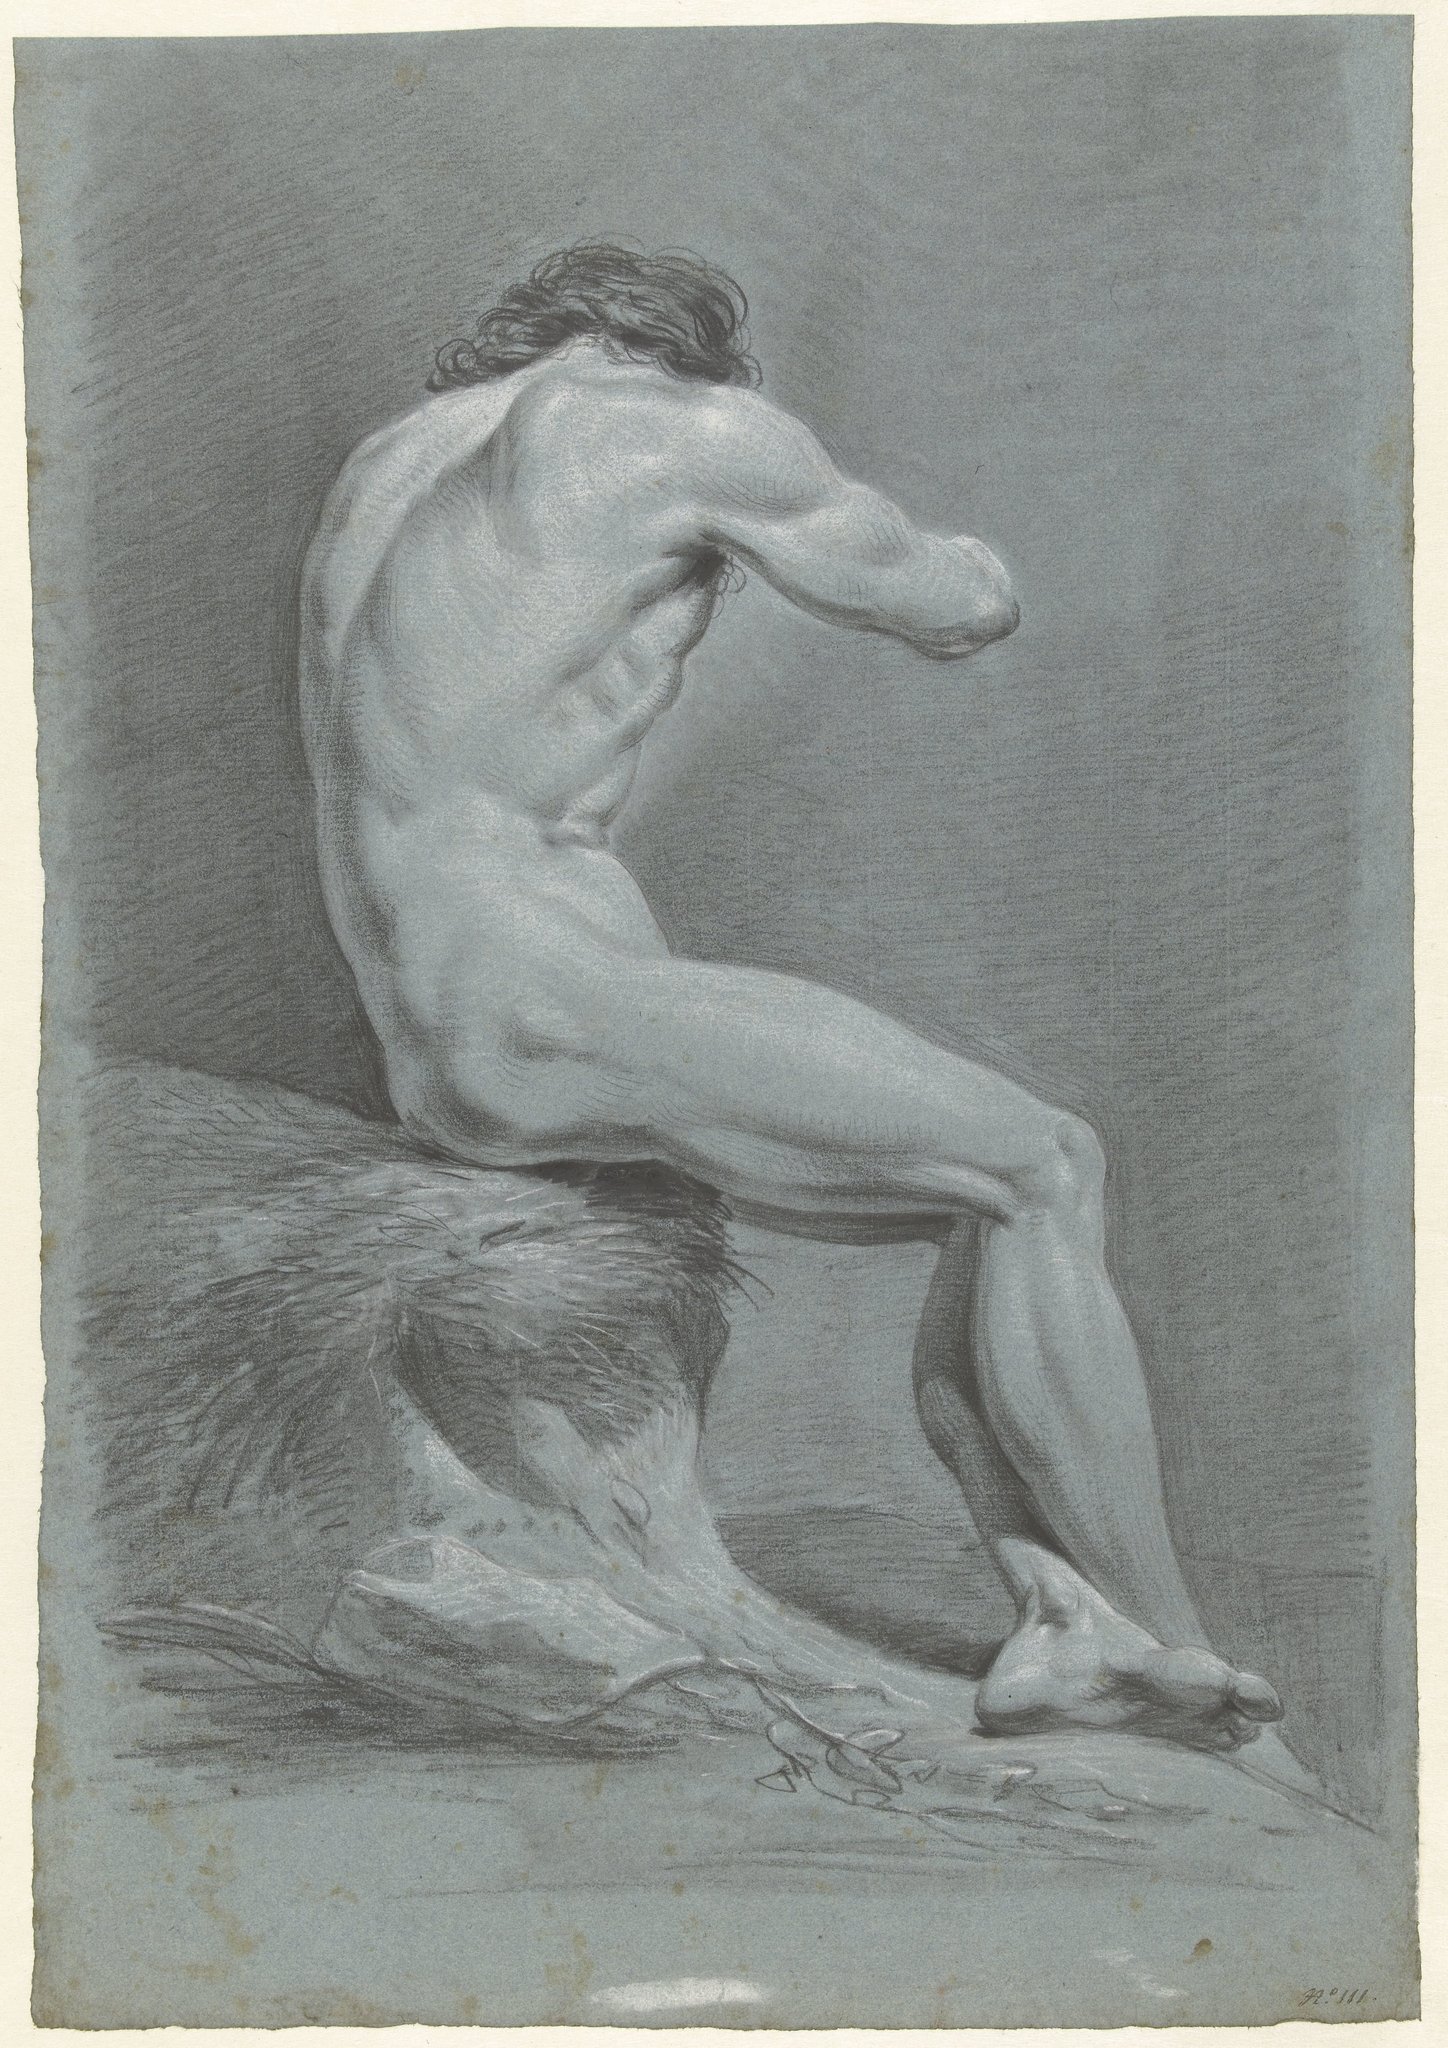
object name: drawing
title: Studie van zittend mannelijk naakt, van opzij gezien, naar rechts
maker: hermanus fock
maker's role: conservator, draughtsman, painter, print maker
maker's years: 1766-1822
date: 1776-1822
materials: chalk, paper